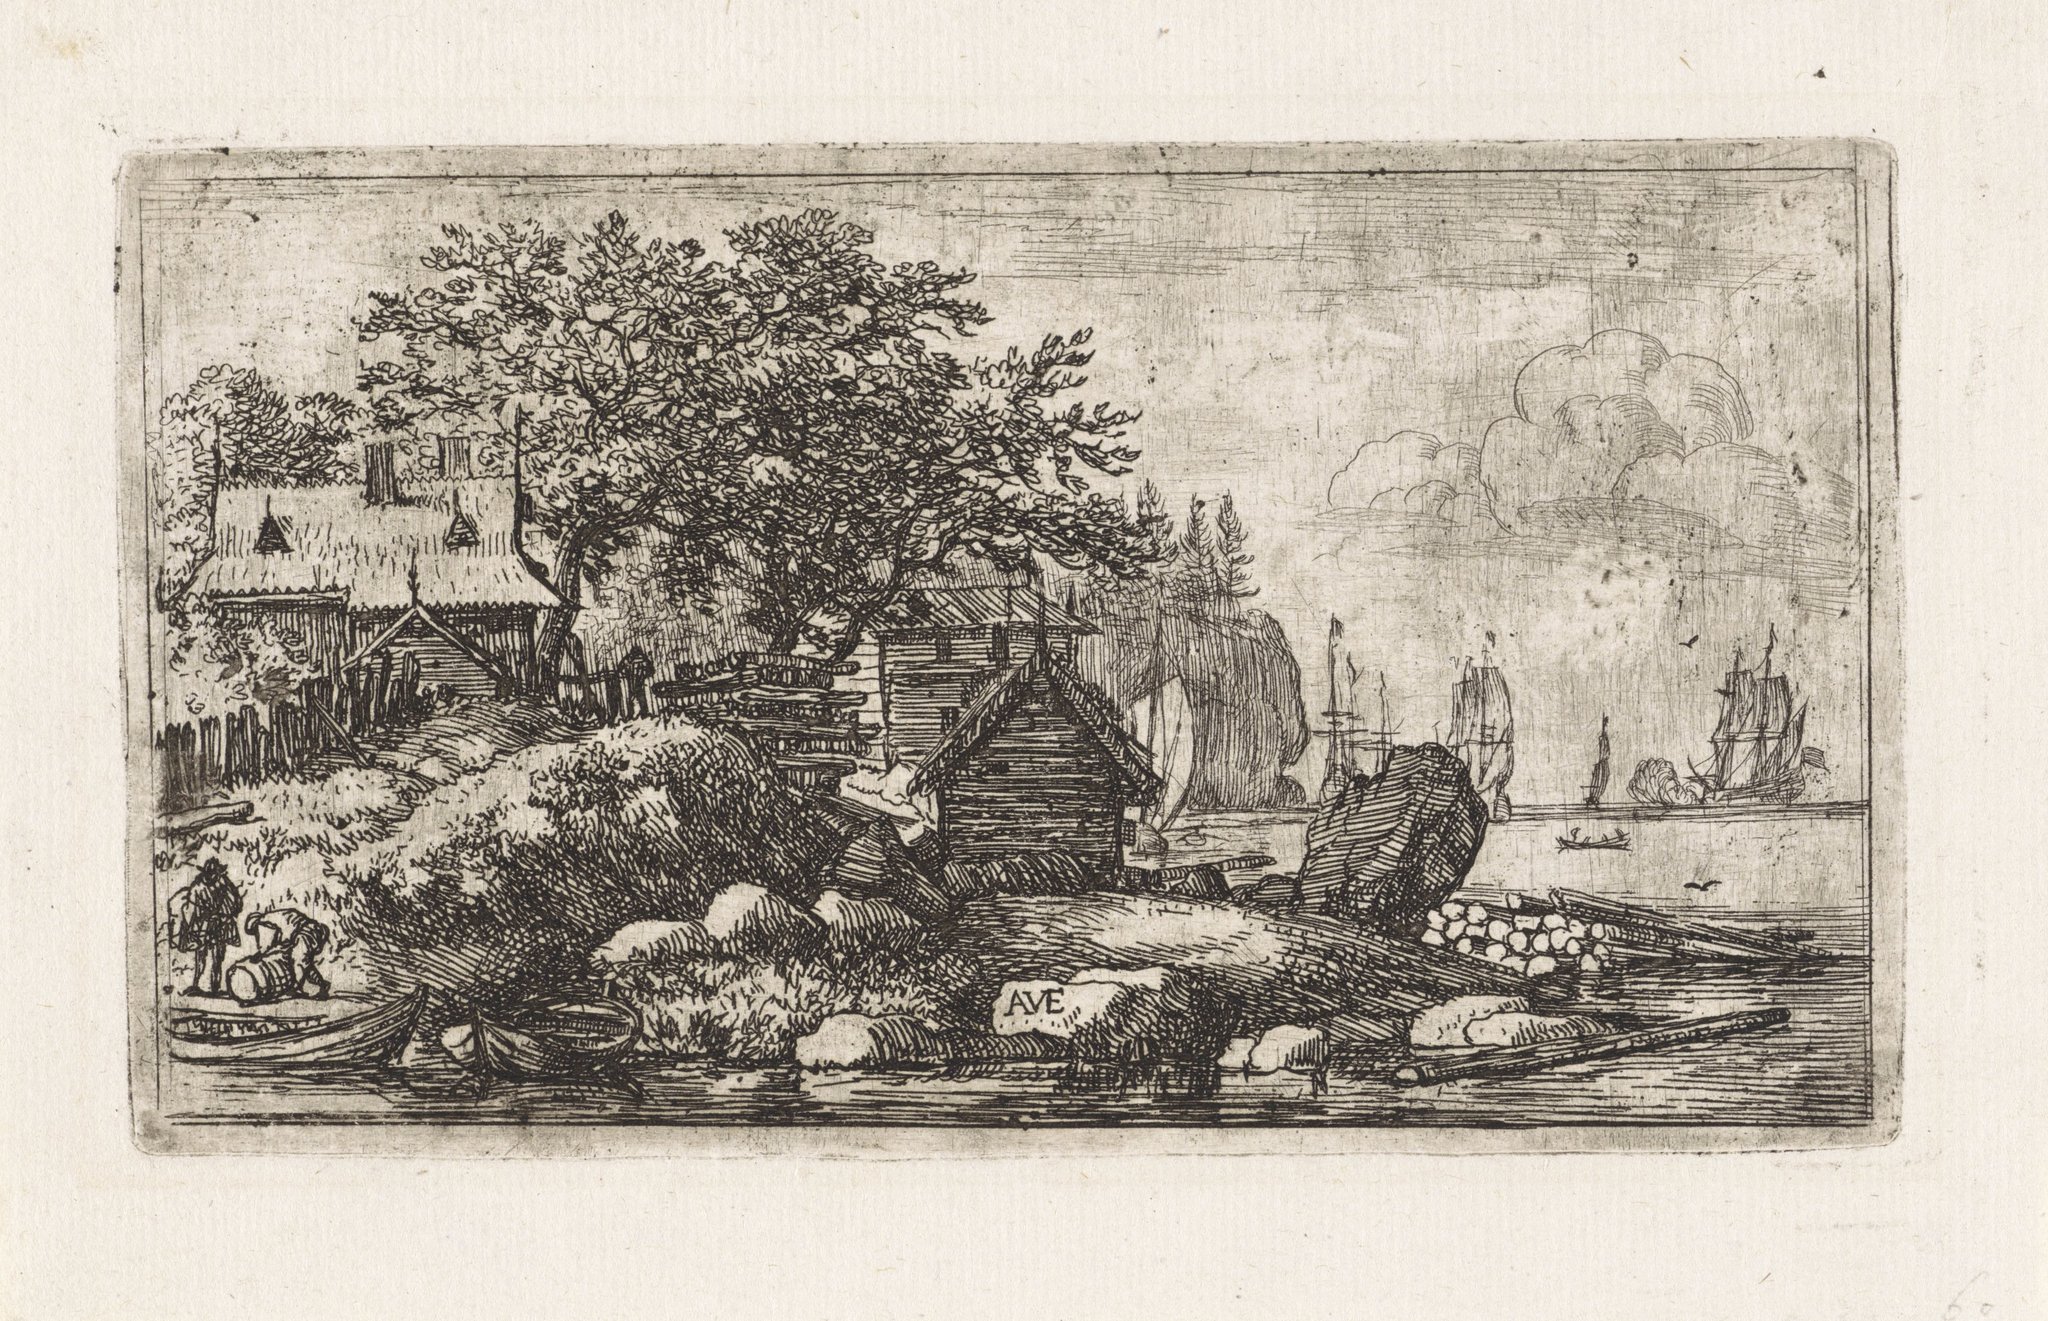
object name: print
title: Twee lege boten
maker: allaert van everdingen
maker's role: draughtsman, painter, print maker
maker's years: 1621-1675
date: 1631-1675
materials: paper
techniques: etching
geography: netherlands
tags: river (+ landscape with figures, staffage)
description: Gezicht op een gehucht met enkele houten huizen aan het water. Op de voorgrond twee roeiboten en op de oever twee personen bij een ton. Op de achtergrond zeilschepen.